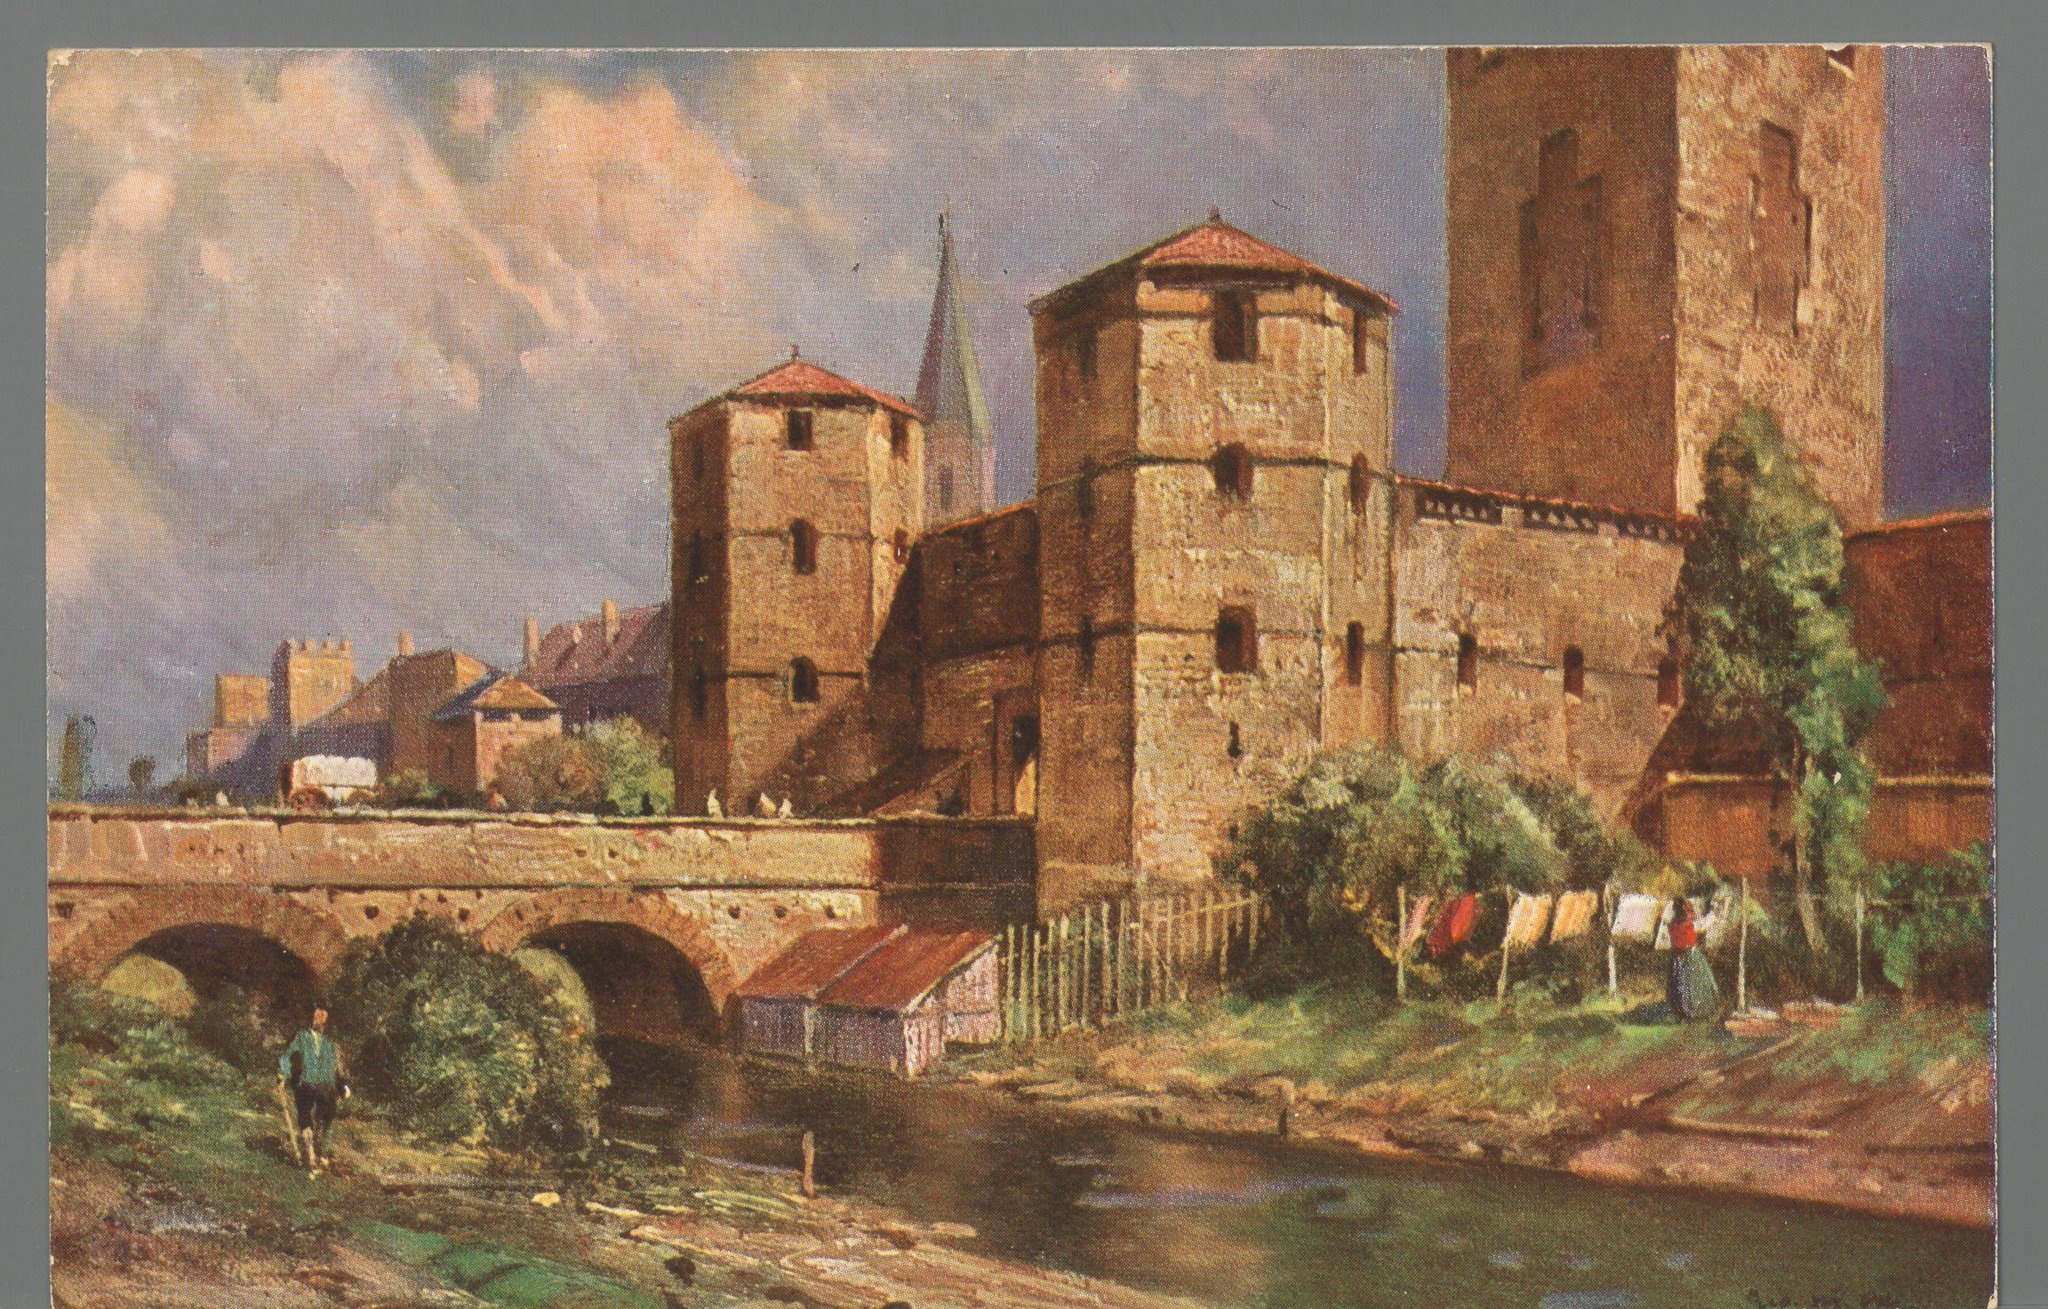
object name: photomechanical print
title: Alt-München. Sendlingertor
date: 1905-1930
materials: cardboard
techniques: color autotype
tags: city-walls, canals, waters (in city), bridge in city across river, canal, etc., city-gate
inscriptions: monogram: ‘T.H.’, inscription: ‘Geo. M.M.’